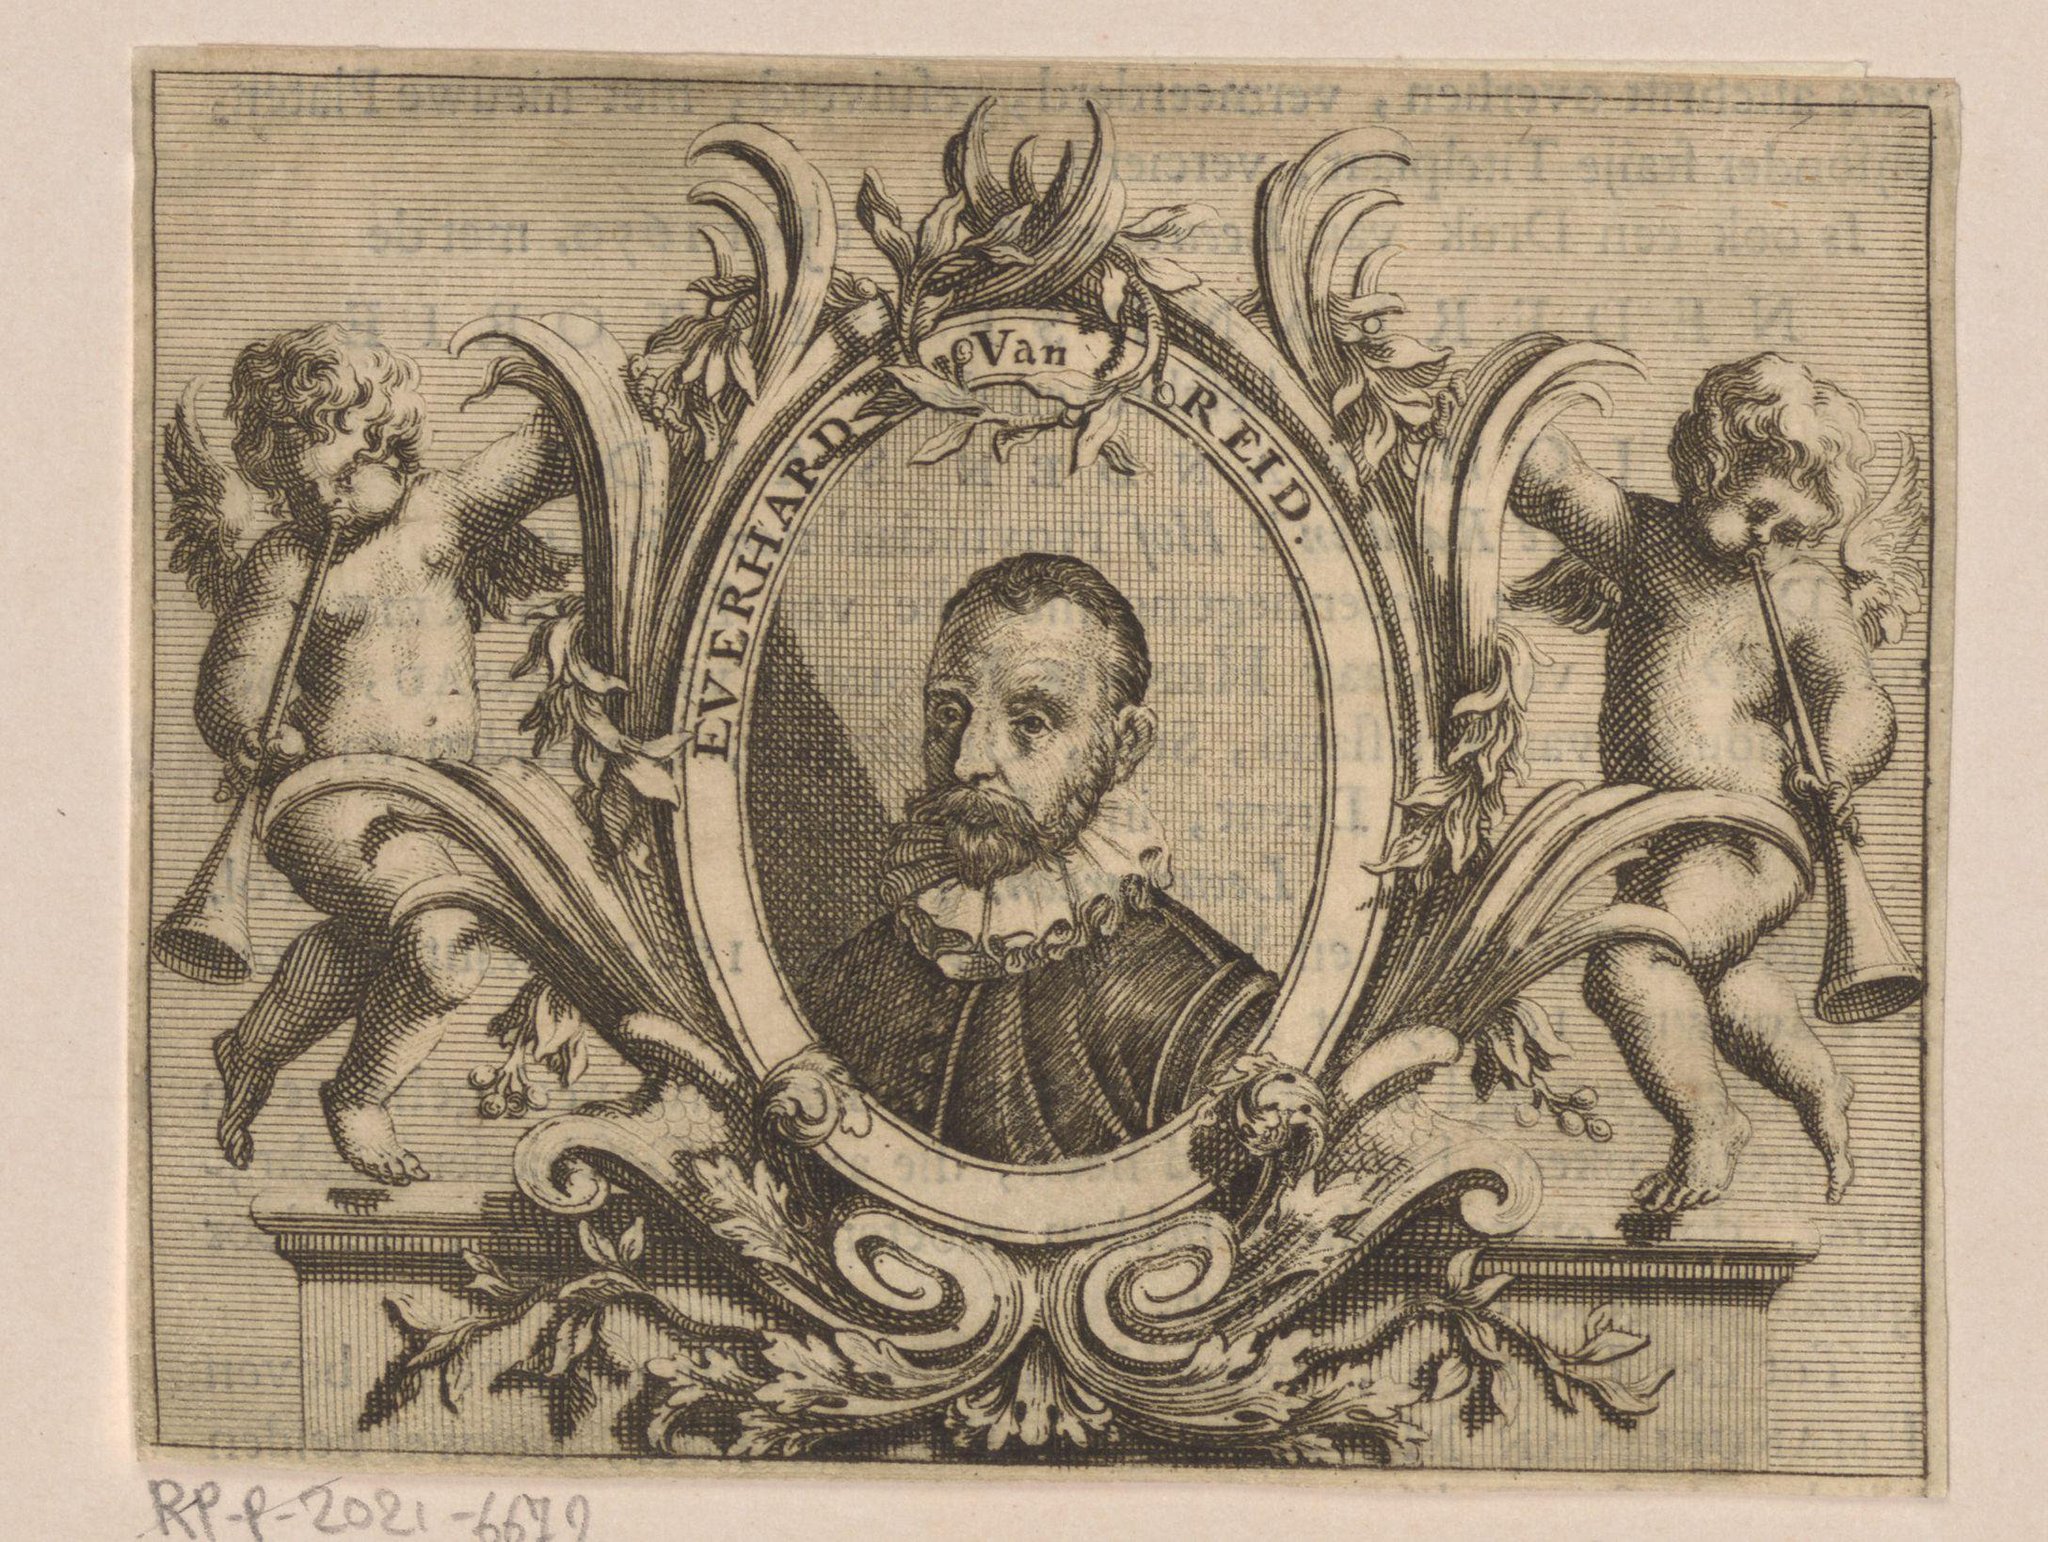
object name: book illustration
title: Portret van Everard van Reyd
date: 1701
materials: paper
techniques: engraving, etching, letterpress printing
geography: leiden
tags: deventer, everard van reyd, historical persons, cupids: 'amores', 'amoretti', 'putti'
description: Prent uit: Pars, Adriaan. Index Batavicus of naamrol van de Batavise en Hollandse schrijvers (...). Leiden: Abraham de Swart, 1701.